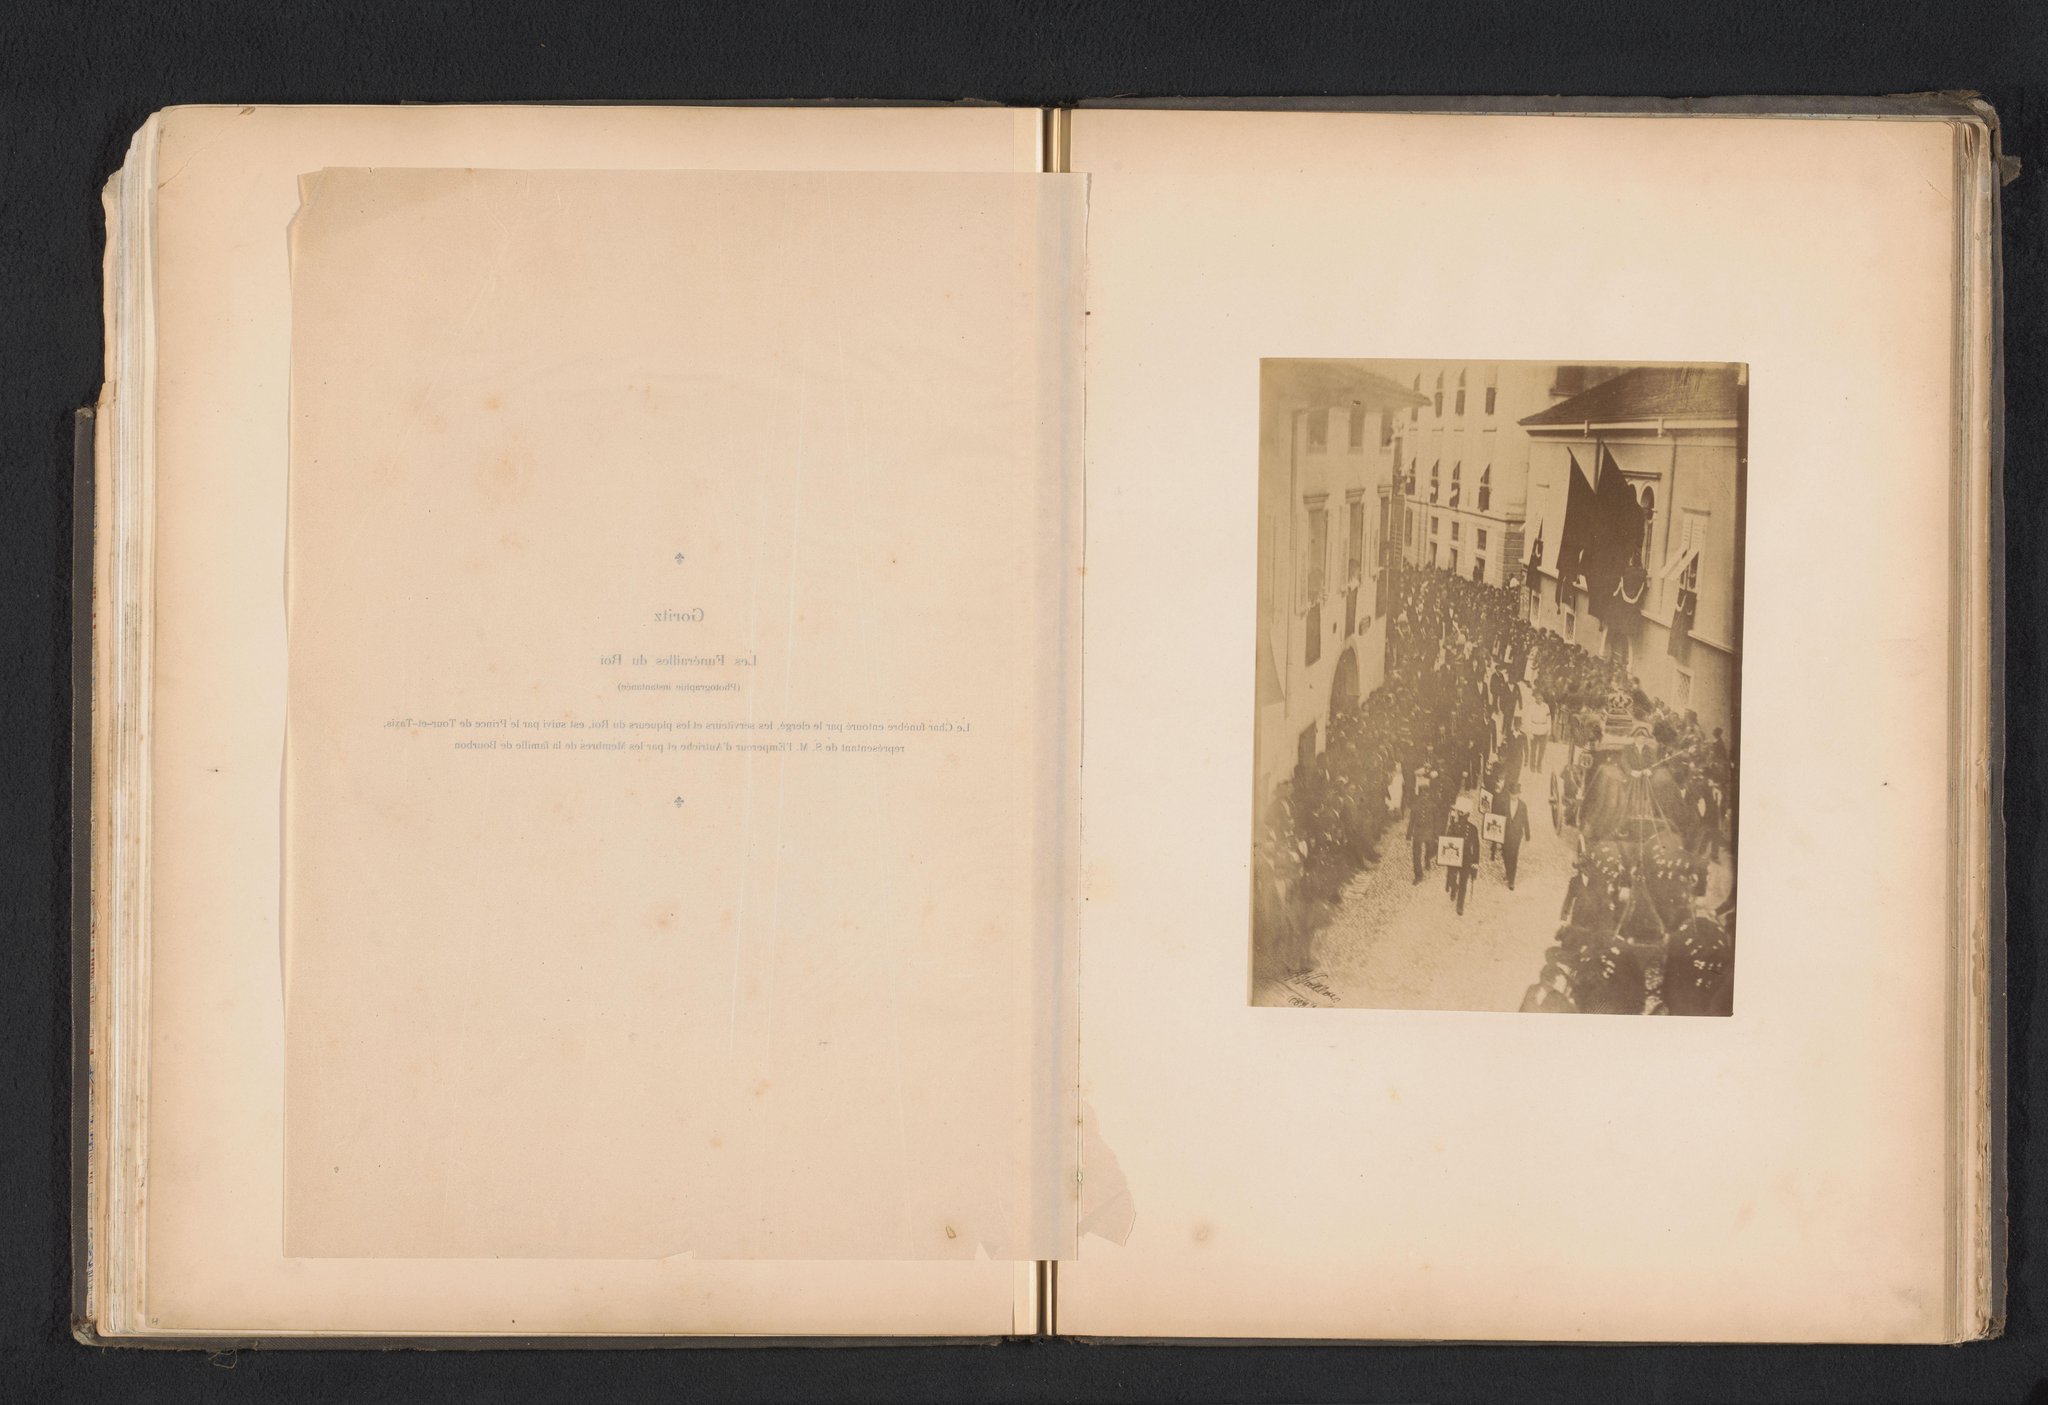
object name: photograph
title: Begrafenisstoet van Henri d'Artois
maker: a. vallois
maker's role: fotograaf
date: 1878-1883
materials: photographic support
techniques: albumen print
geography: göritz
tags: cortege, funeral procession